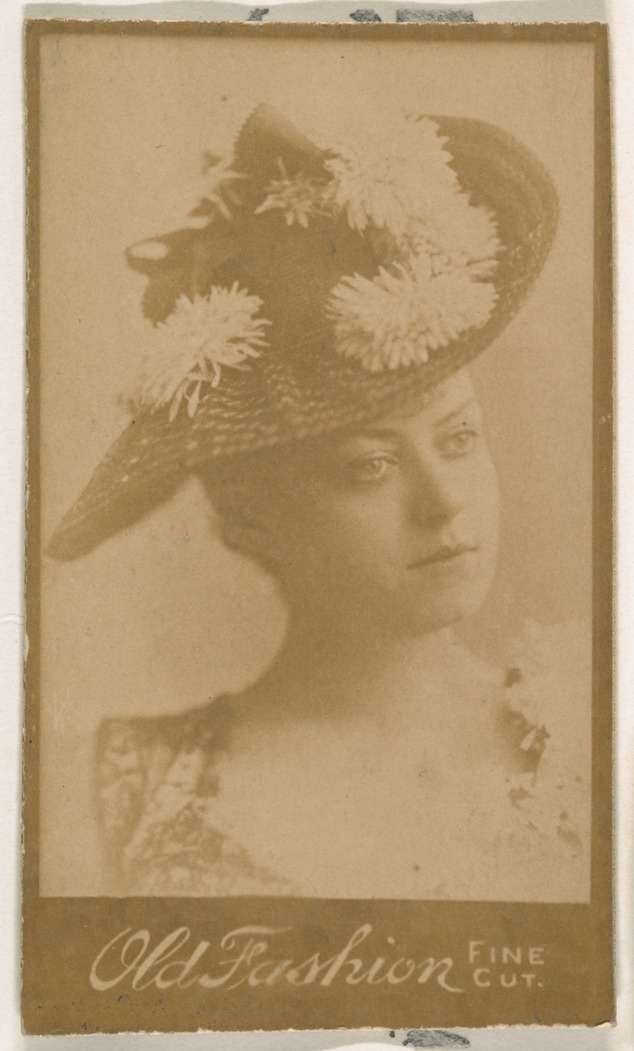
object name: photograph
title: Actress wearing floral hat, from the Actresses series (N664) promoting Old Fashion Fine Cut Tobacco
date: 1888-1890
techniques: albumen silver print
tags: portraits,women,actresses